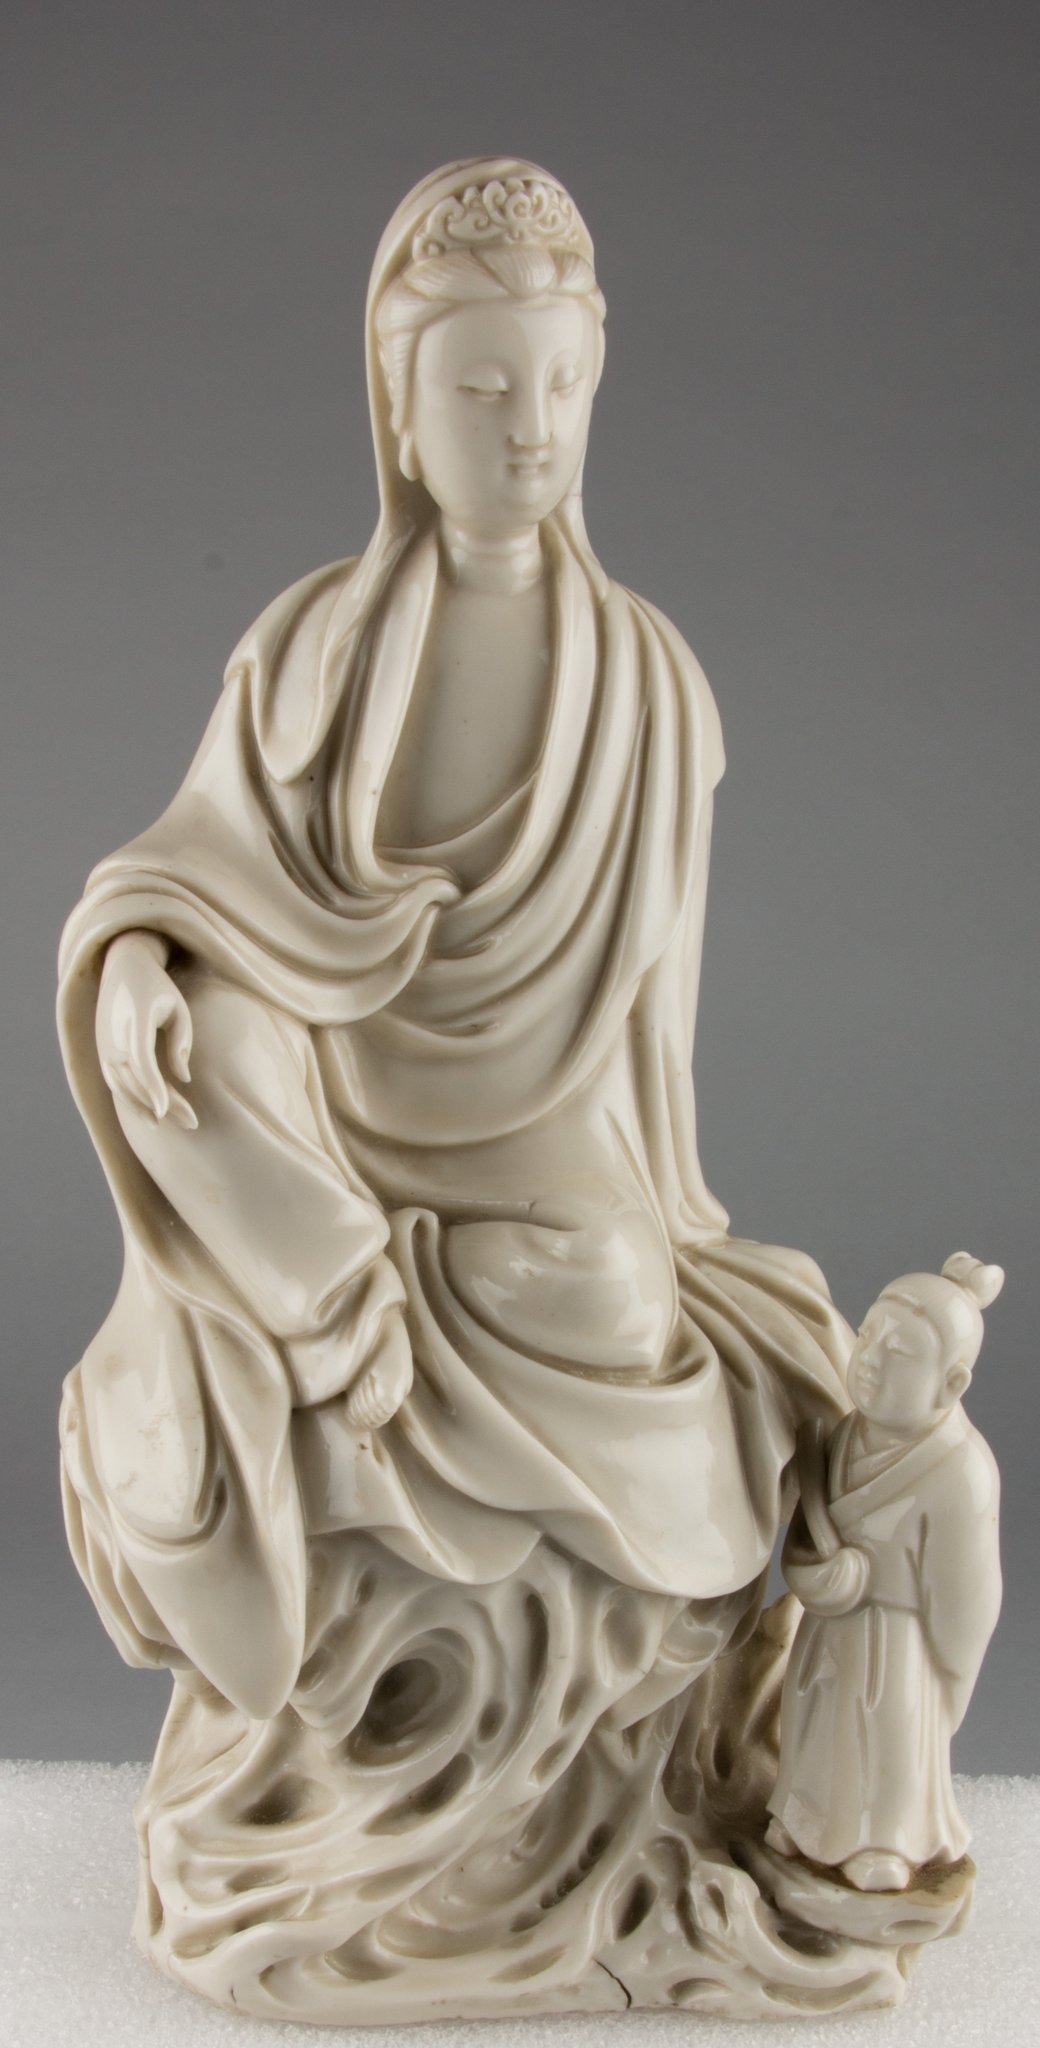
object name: figure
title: Seated bodhisattva Guanyin with an attendant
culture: chinese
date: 1701-1800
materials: glaze, ivory, porcelain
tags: men,buddhism,bodhisattvas